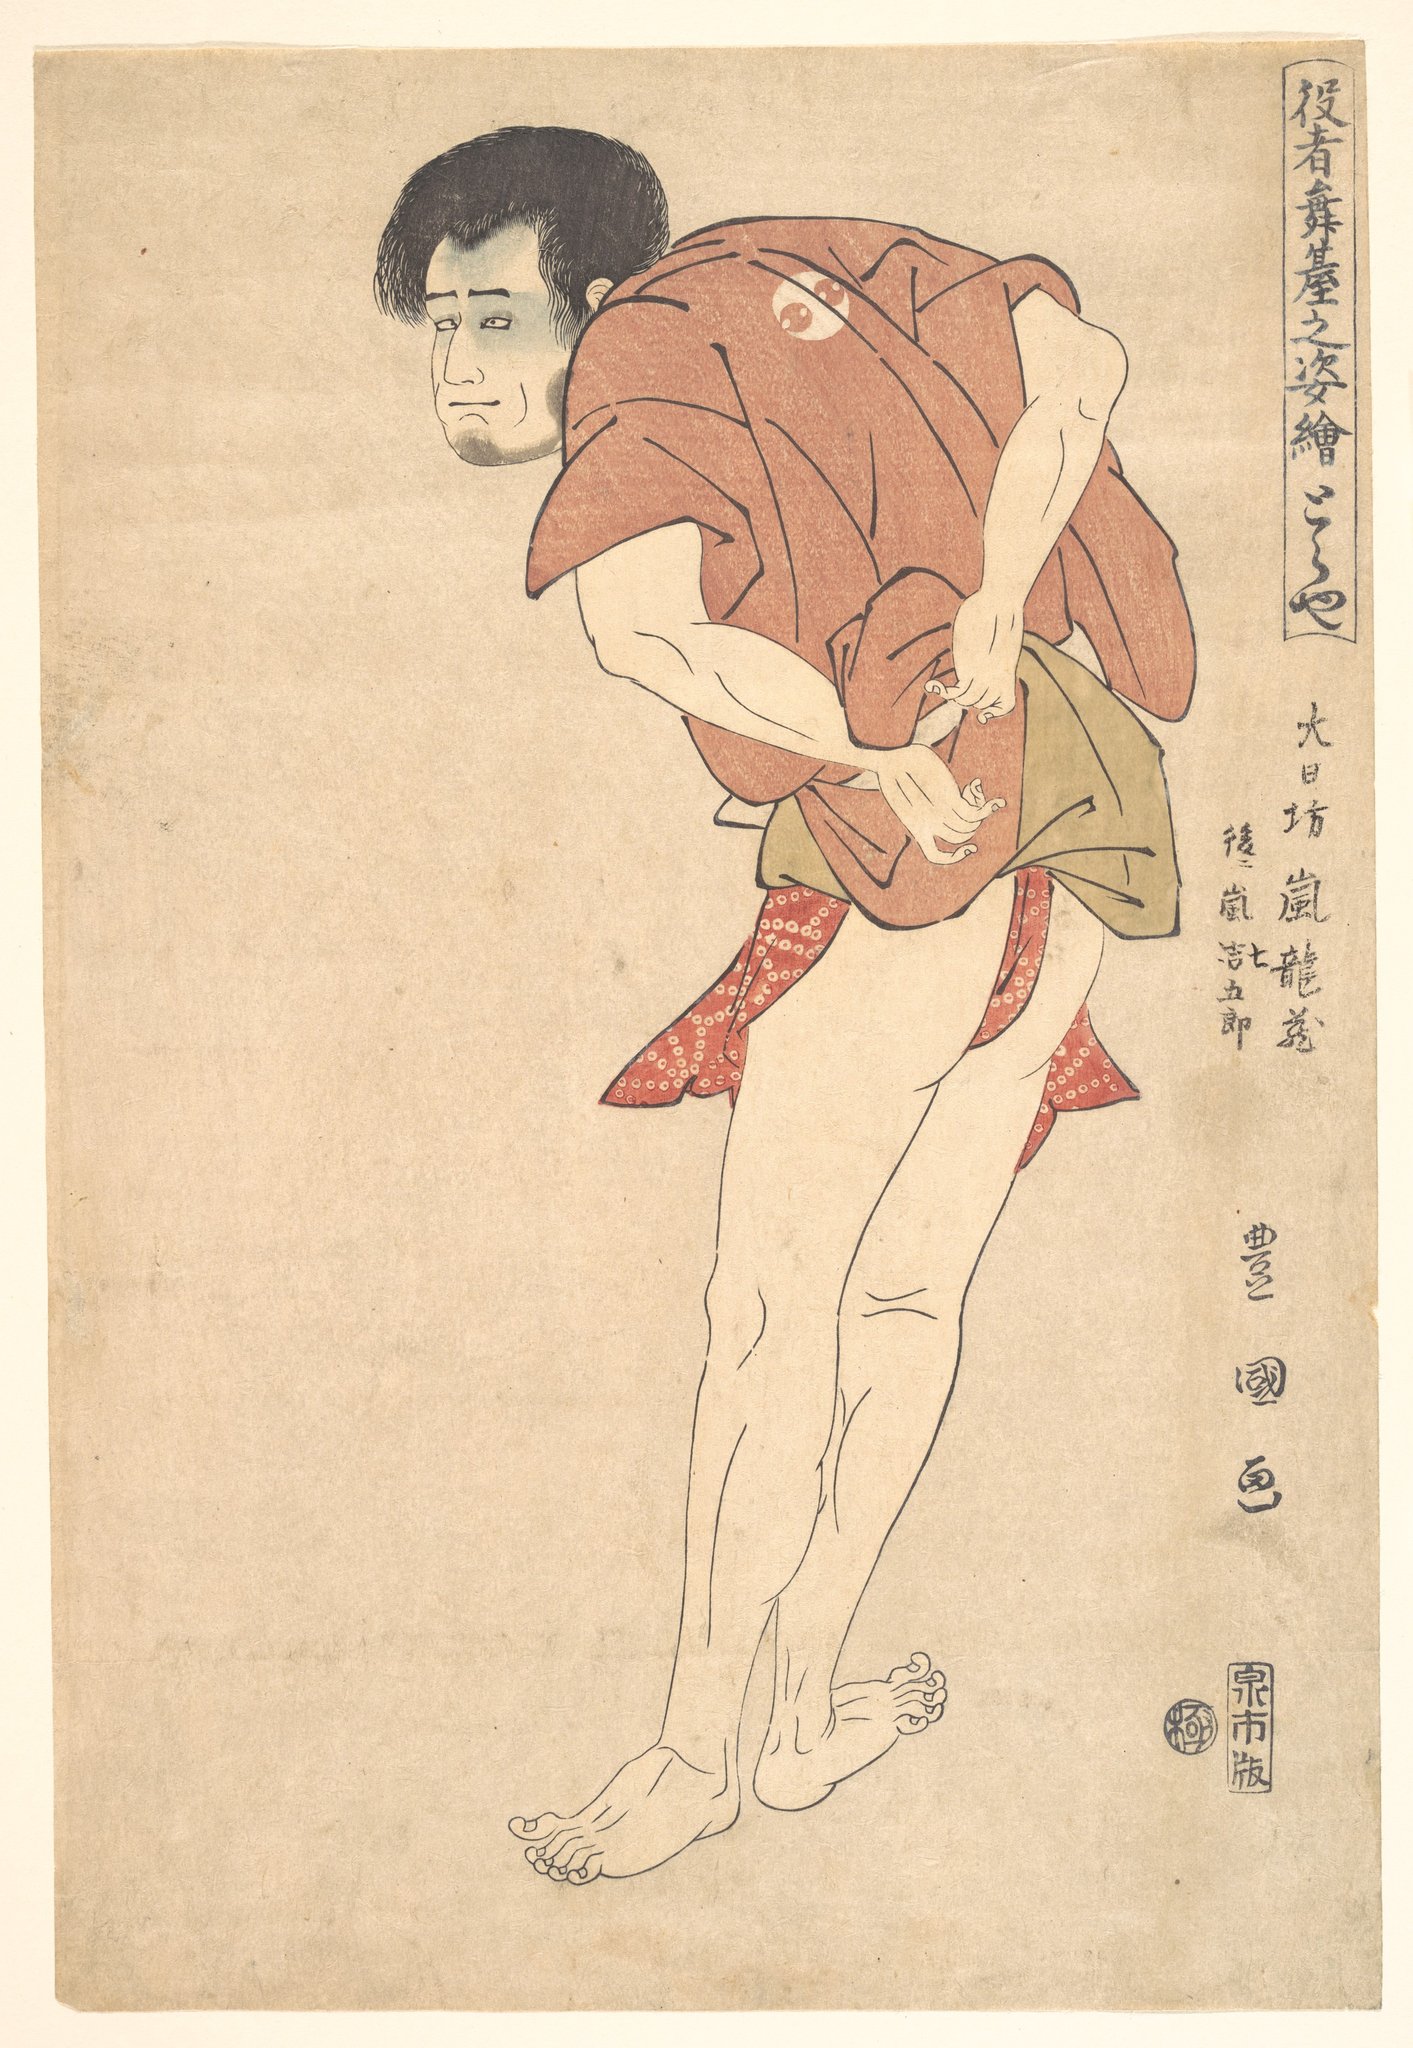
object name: print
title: The actor Arashi Ryuzo later known as Arashi Shichigoro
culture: japanese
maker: utagawa toyokuni i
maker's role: artist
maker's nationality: japanese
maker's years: 1769-1825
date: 1701-1900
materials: ink, paper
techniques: woodblock print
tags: men,actors